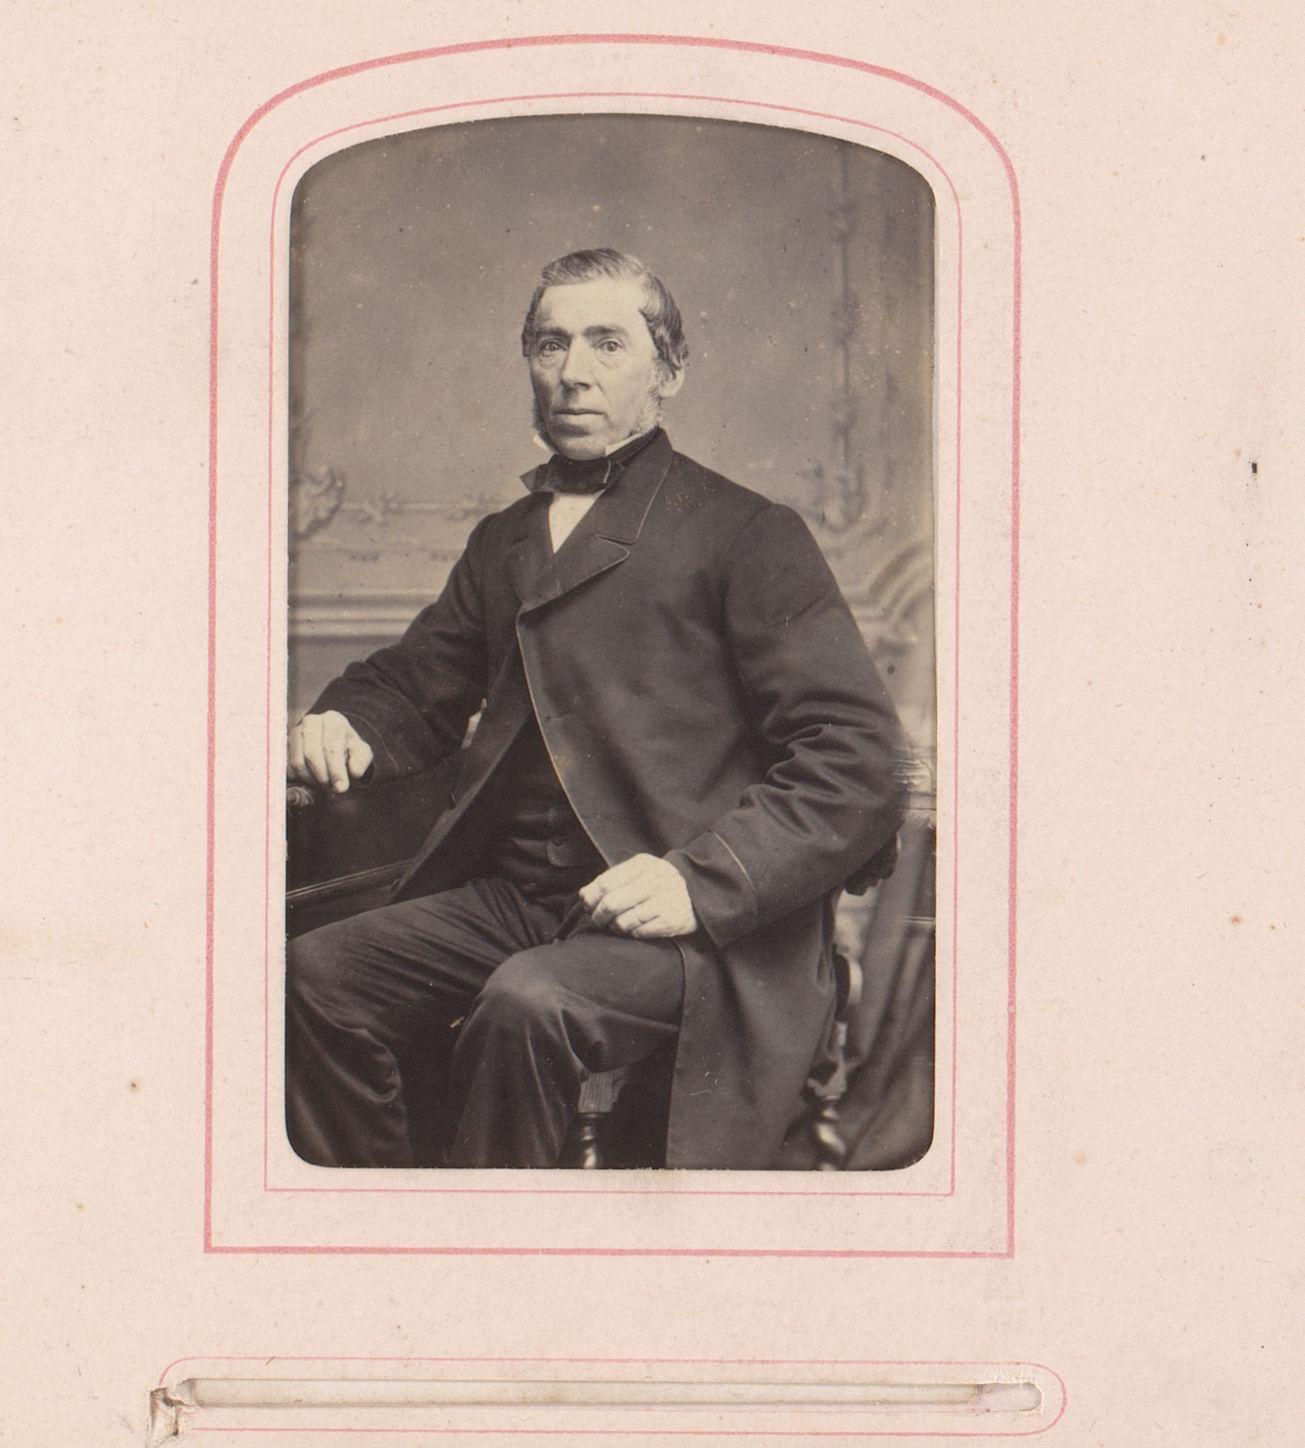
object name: album leaf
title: Portret van een zittende man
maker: hermanus philippus jacobus schuiten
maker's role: fotograaf, lijstenmaker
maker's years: 1820-1869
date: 1855-1869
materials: paper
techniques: albumen print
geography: amsterdam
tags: adult man, historical persons, amsterdam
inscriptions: inscription: ‘Atelier de Photographie./ H. Ph. J. Schuiten,/ Amsterdam.’